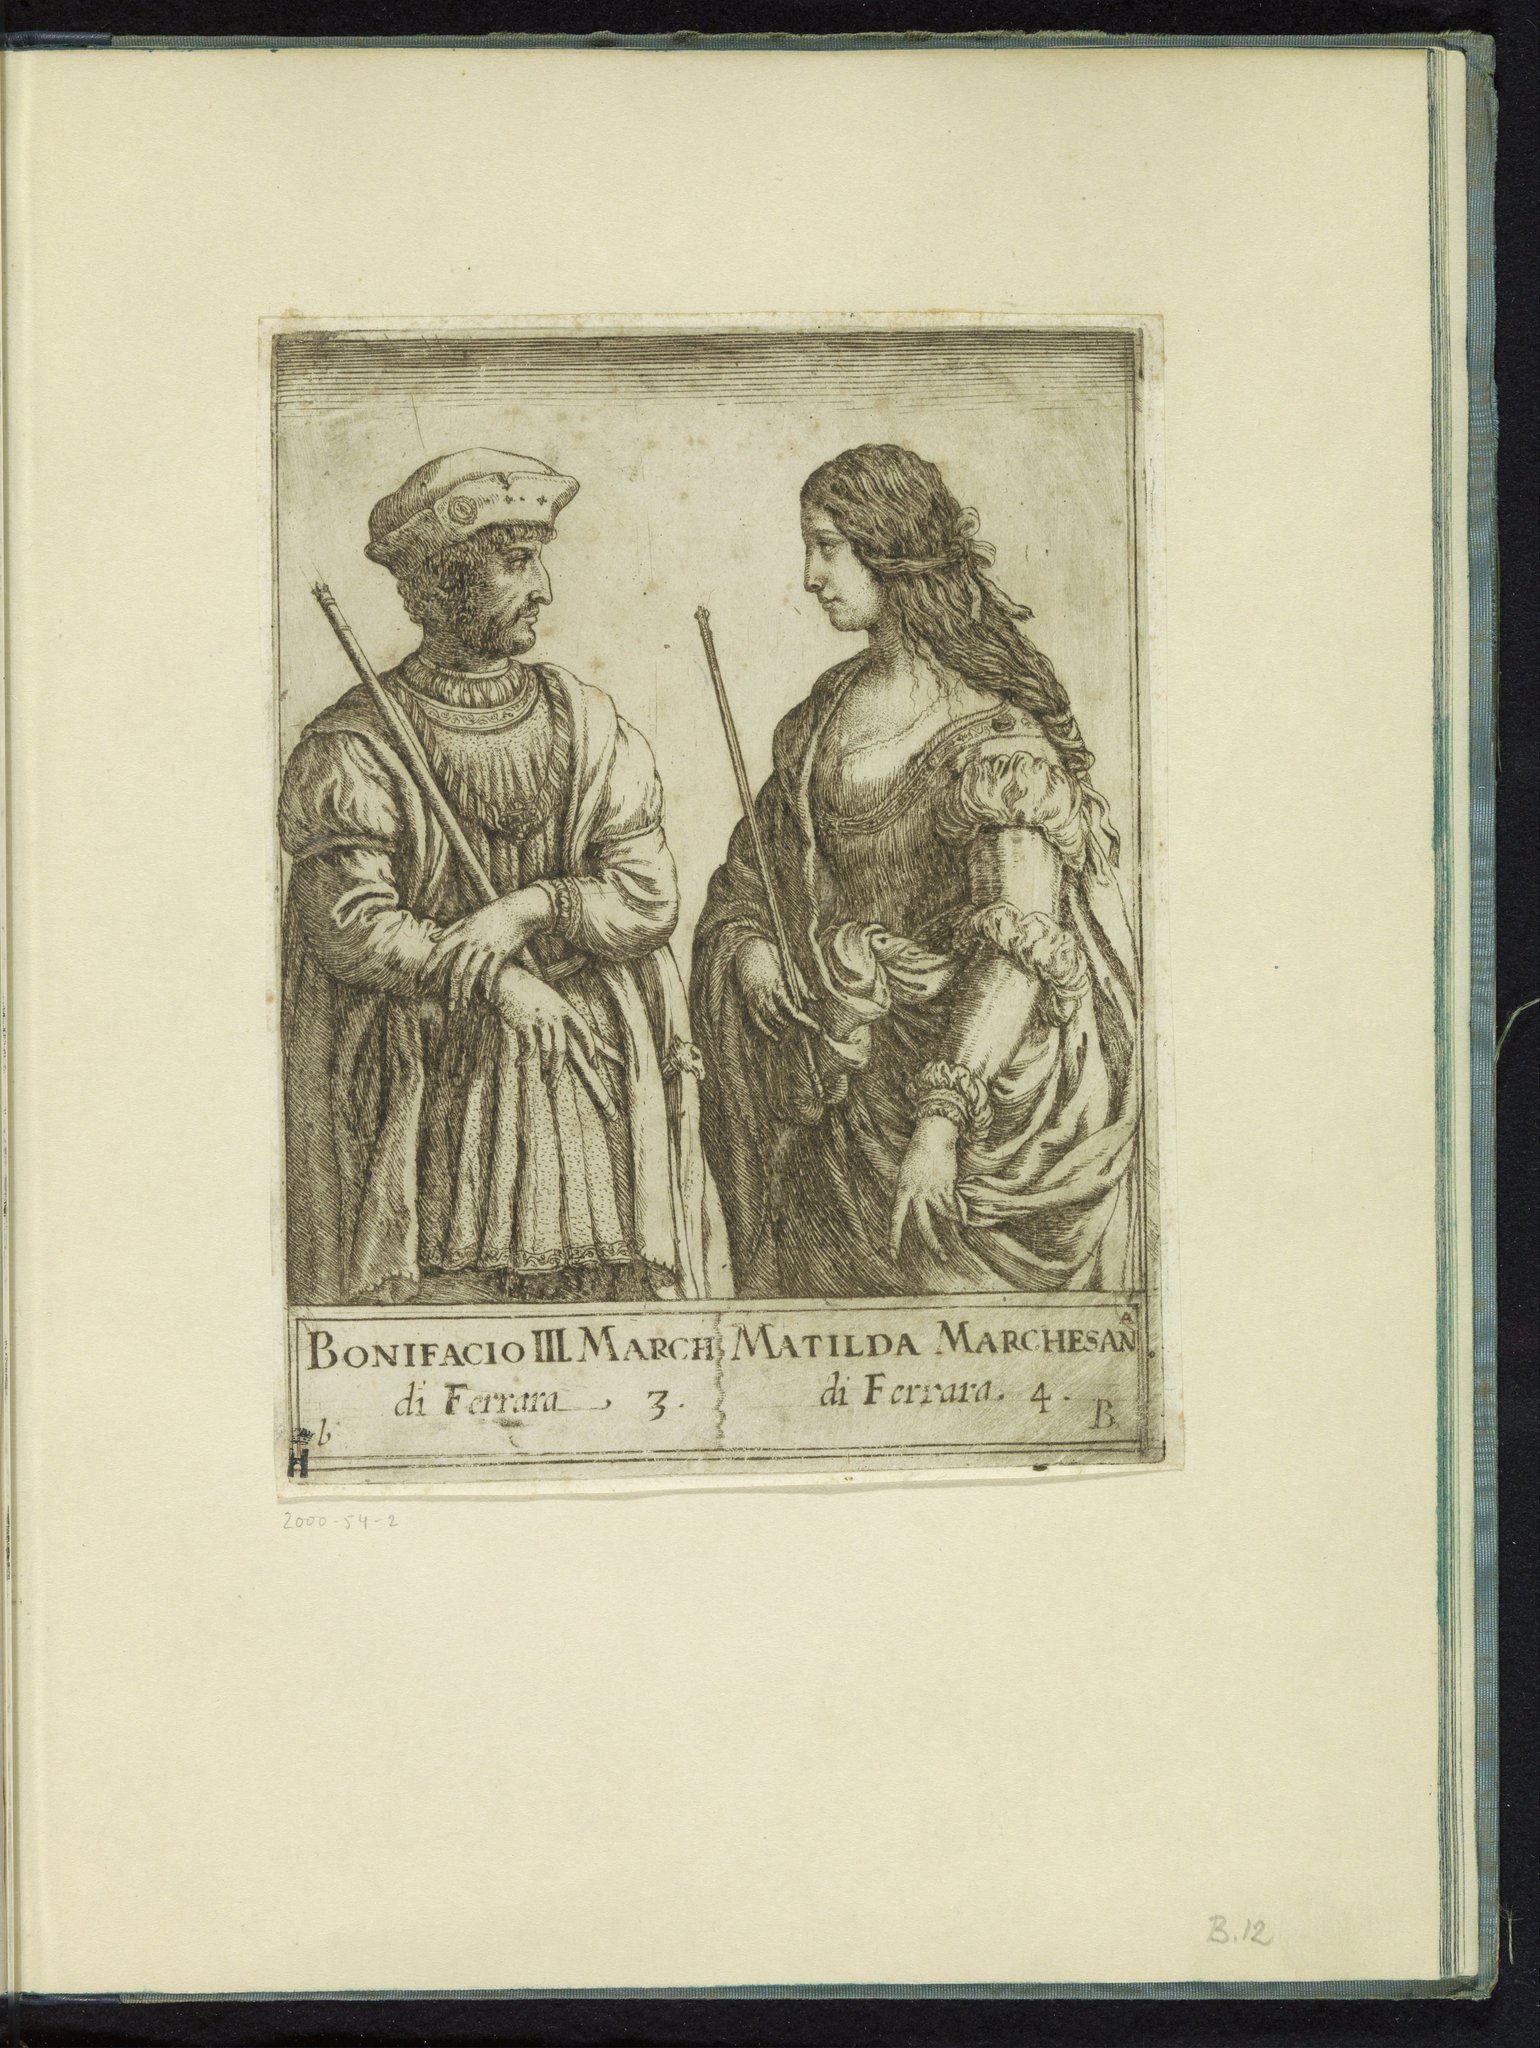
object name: book illustration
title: Dubbelportret van Bonifacio III van Canossa en zijn dochter Matilda van Canossa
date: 1641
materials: paper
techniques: etching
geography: italy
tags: historical persons - bb - woman, historical persons, ruler, sovereign - bb - female ruler, ruler, sovereign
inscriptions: collector's mark: Lugt 1282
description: Prent gebruikt voor Antonio Cariola. Ritratti De' Ser.mi Principi d'Este Sig.ri di Ferrara, Ferrara: Francesco Suzzi, 1641.